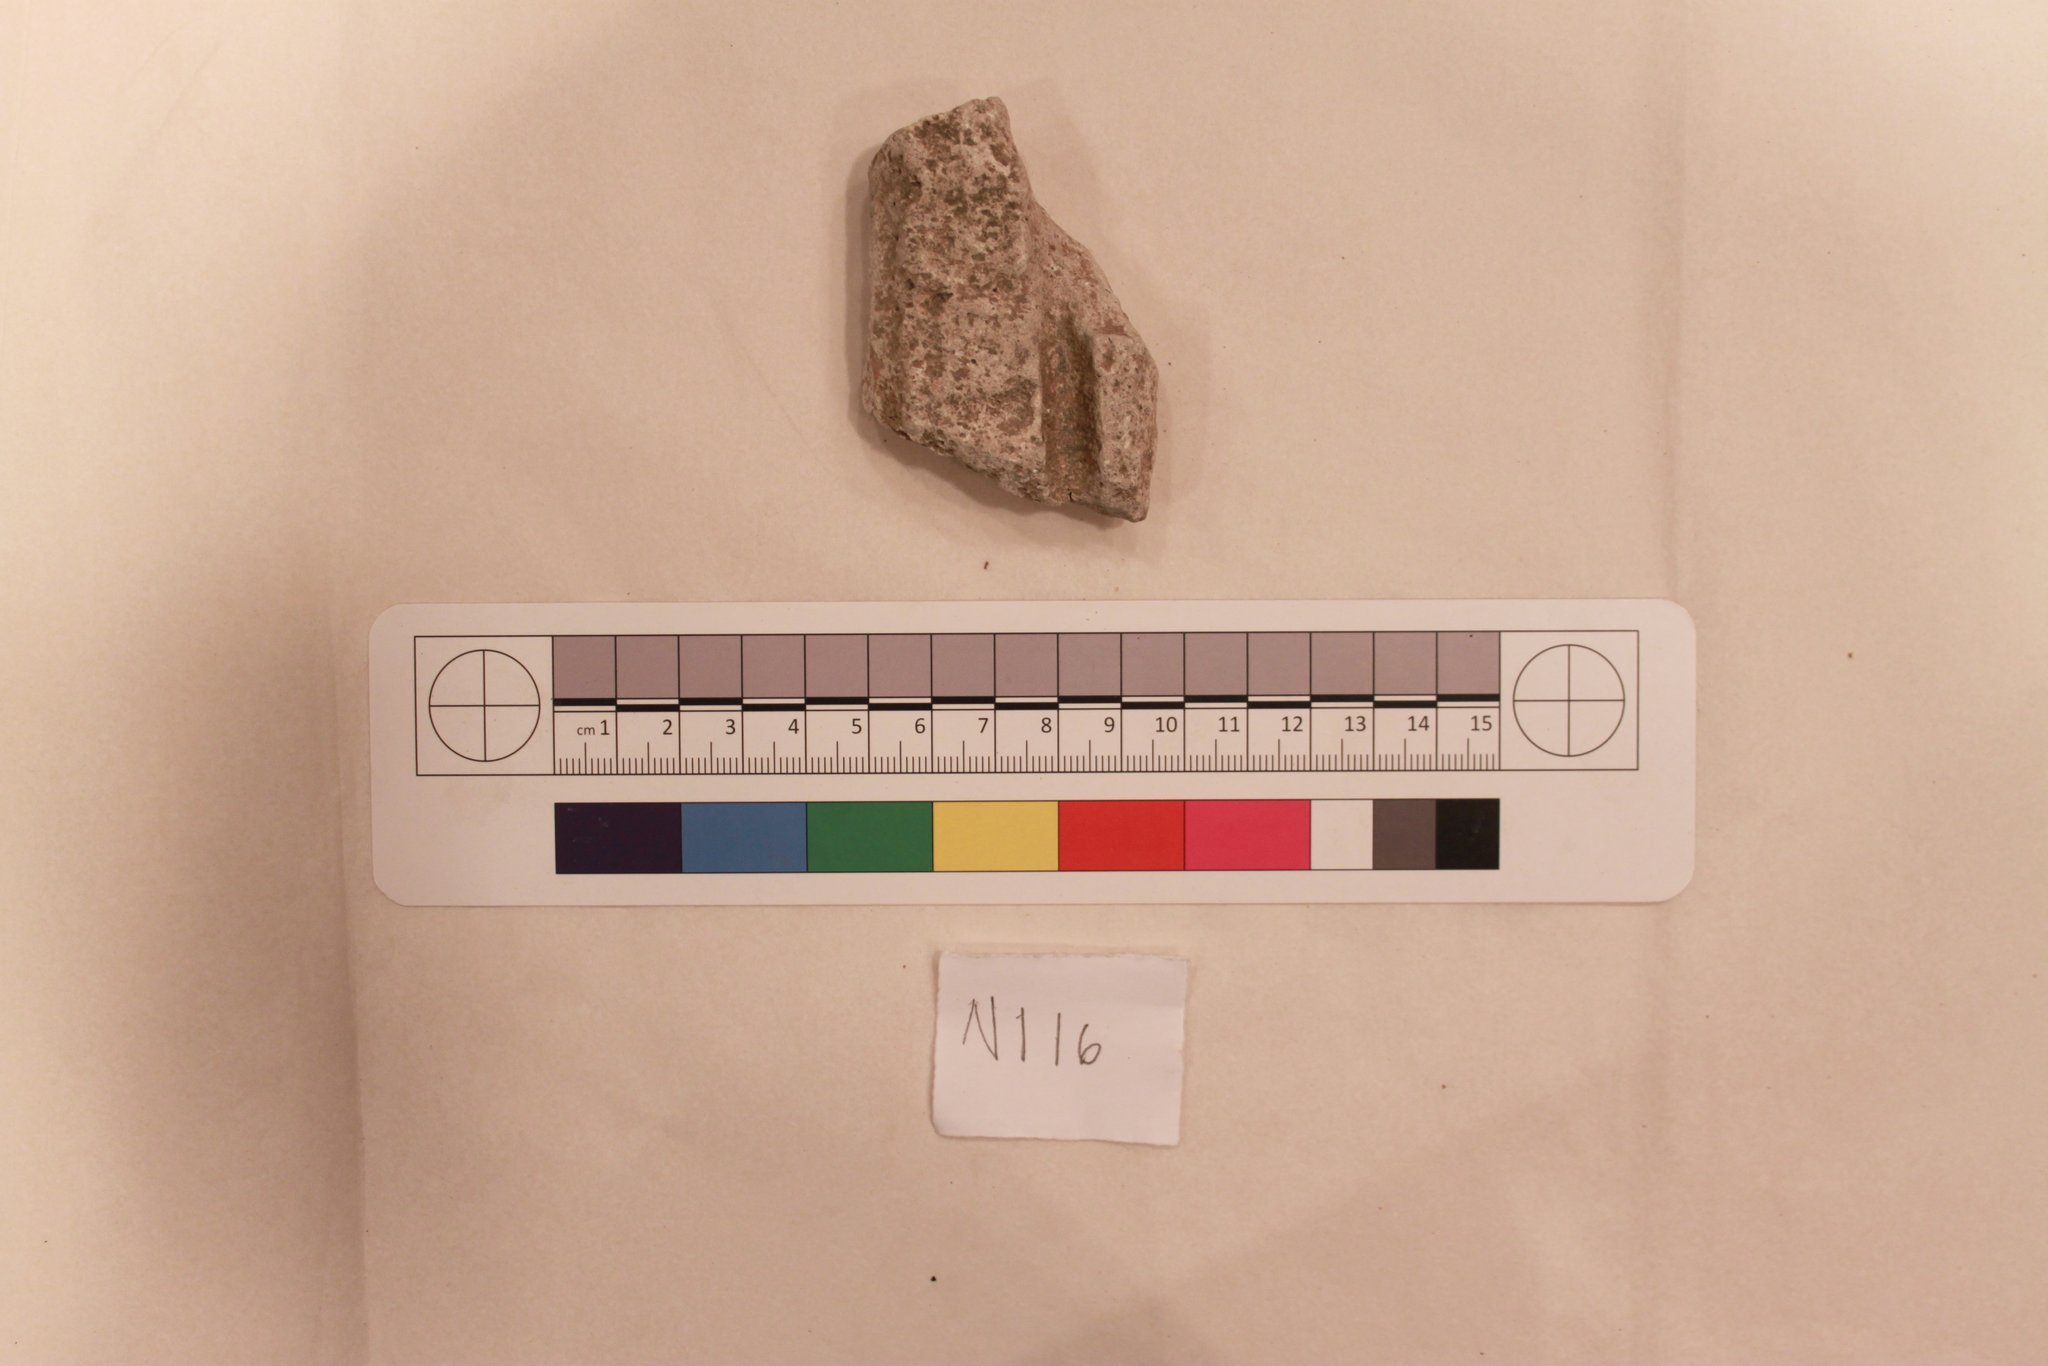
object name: fragment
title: Stucco Fragment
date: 701-1200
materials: plaster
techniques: carving, painting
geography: iran